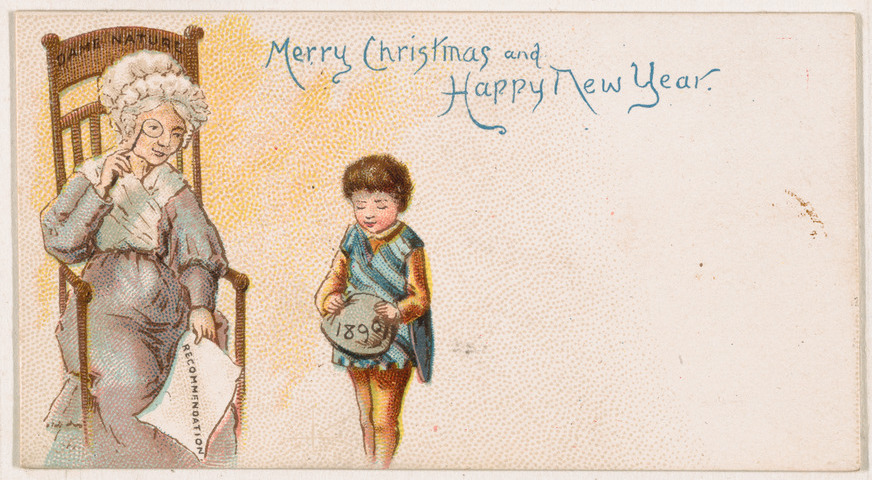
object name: print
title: Merry Christmas and Happy New Year, from the New Years 1890 series (N227) issued by Kinney Bros.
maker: kinney brothers tobacco company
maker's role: publisher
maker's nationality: american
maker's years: 1869-2011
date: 1889-1890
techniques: color lithograph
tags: girls,women